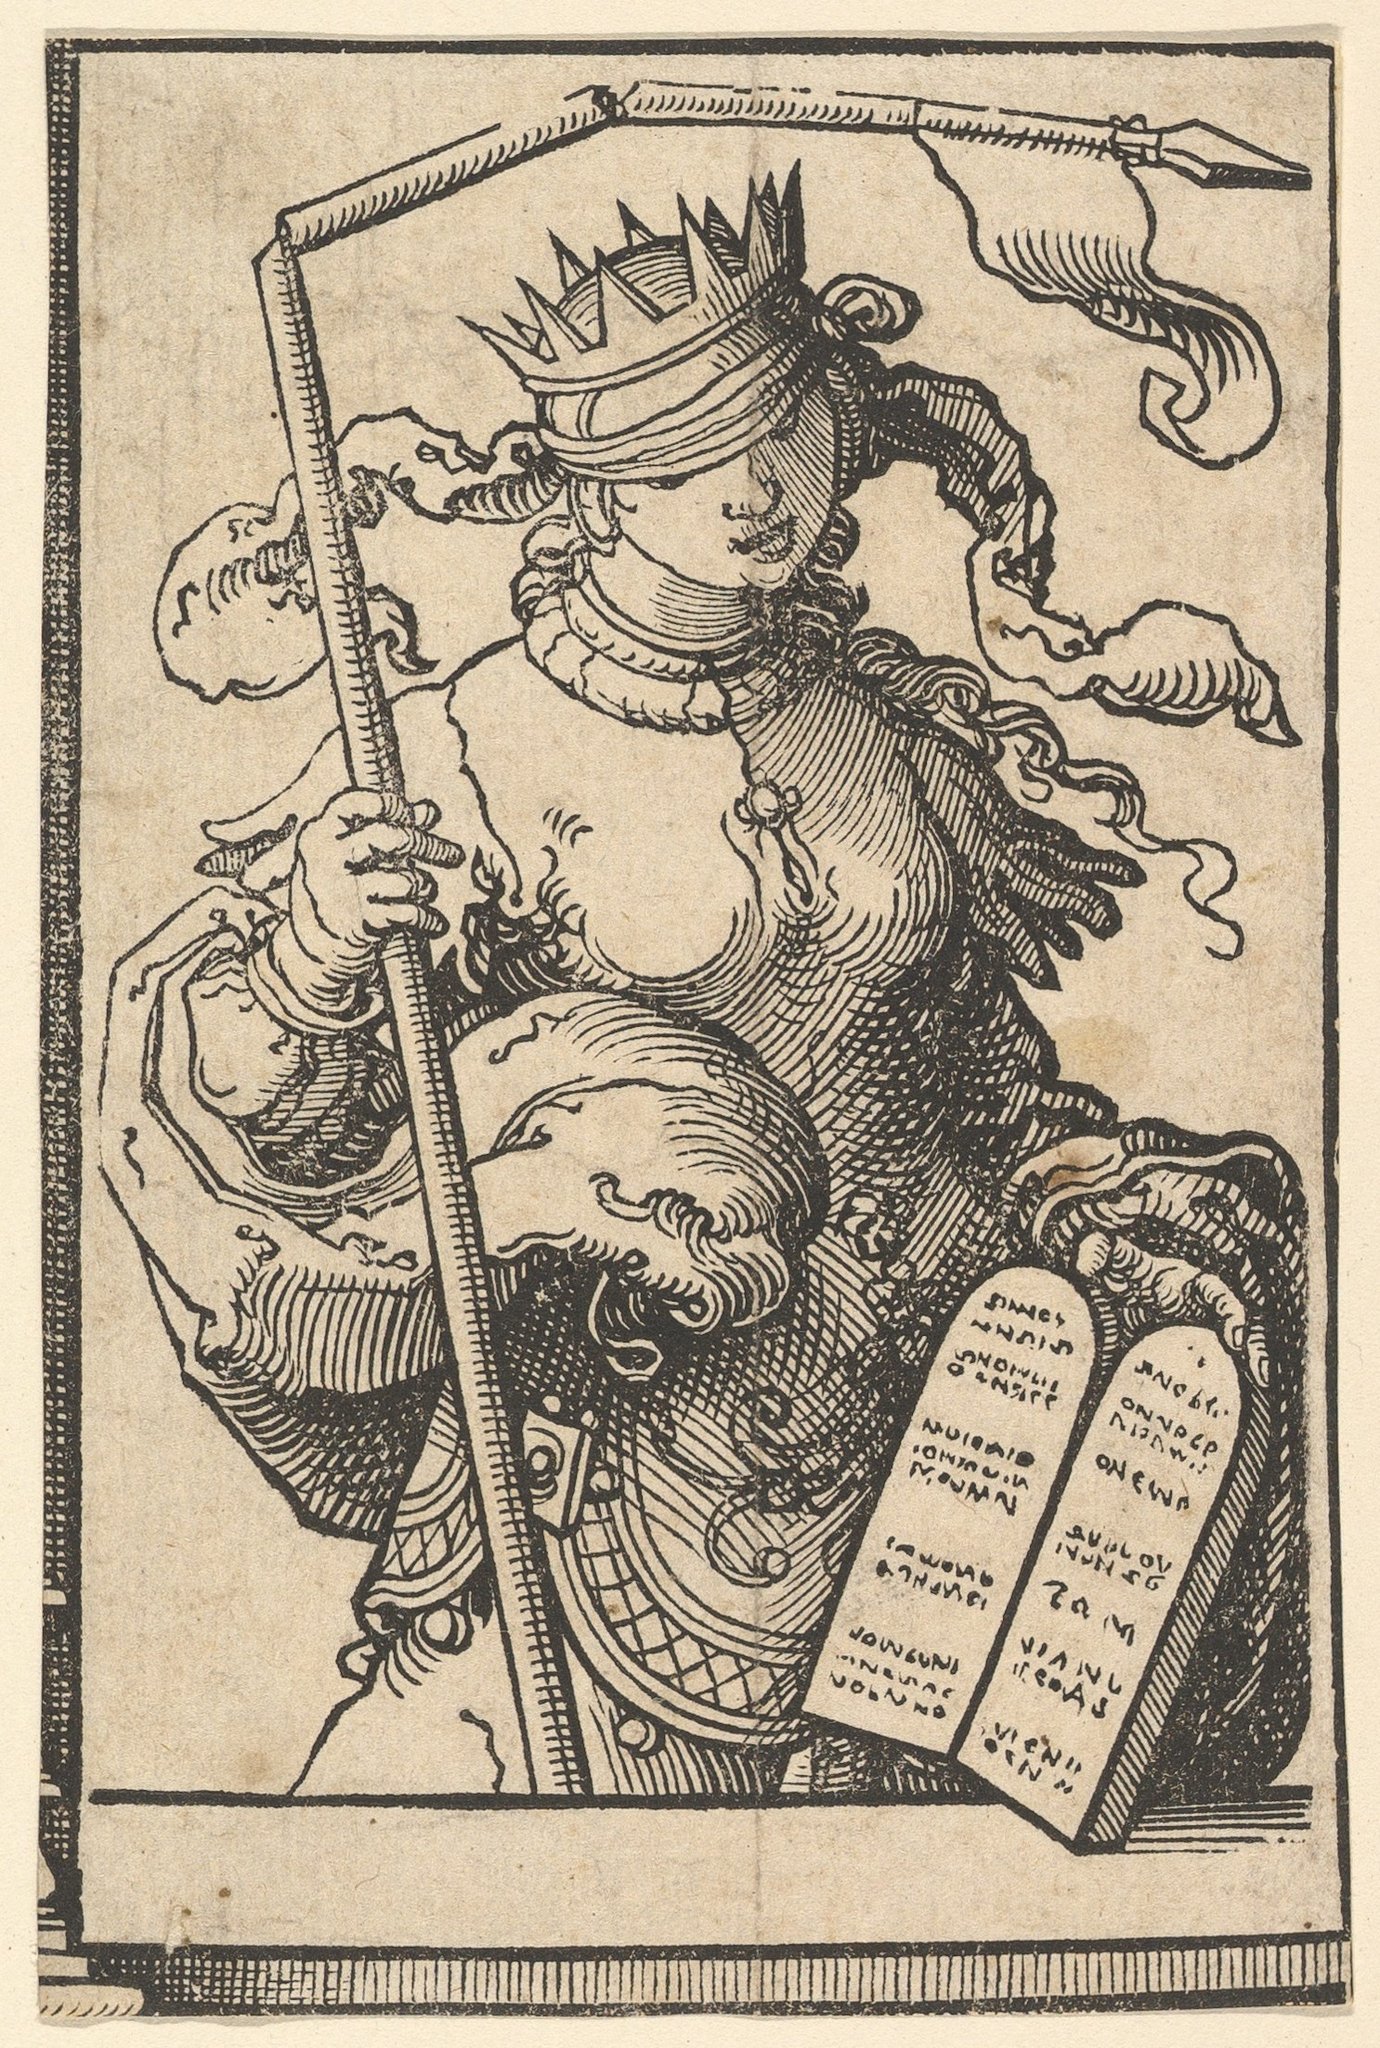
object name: print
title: The Old Testament (or Synagogue), from the series of Sibyls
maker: lucas van leyden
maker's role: artist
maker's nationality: netherlandish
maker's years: 1494-1533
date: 1530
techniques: woodcut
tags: sibyl